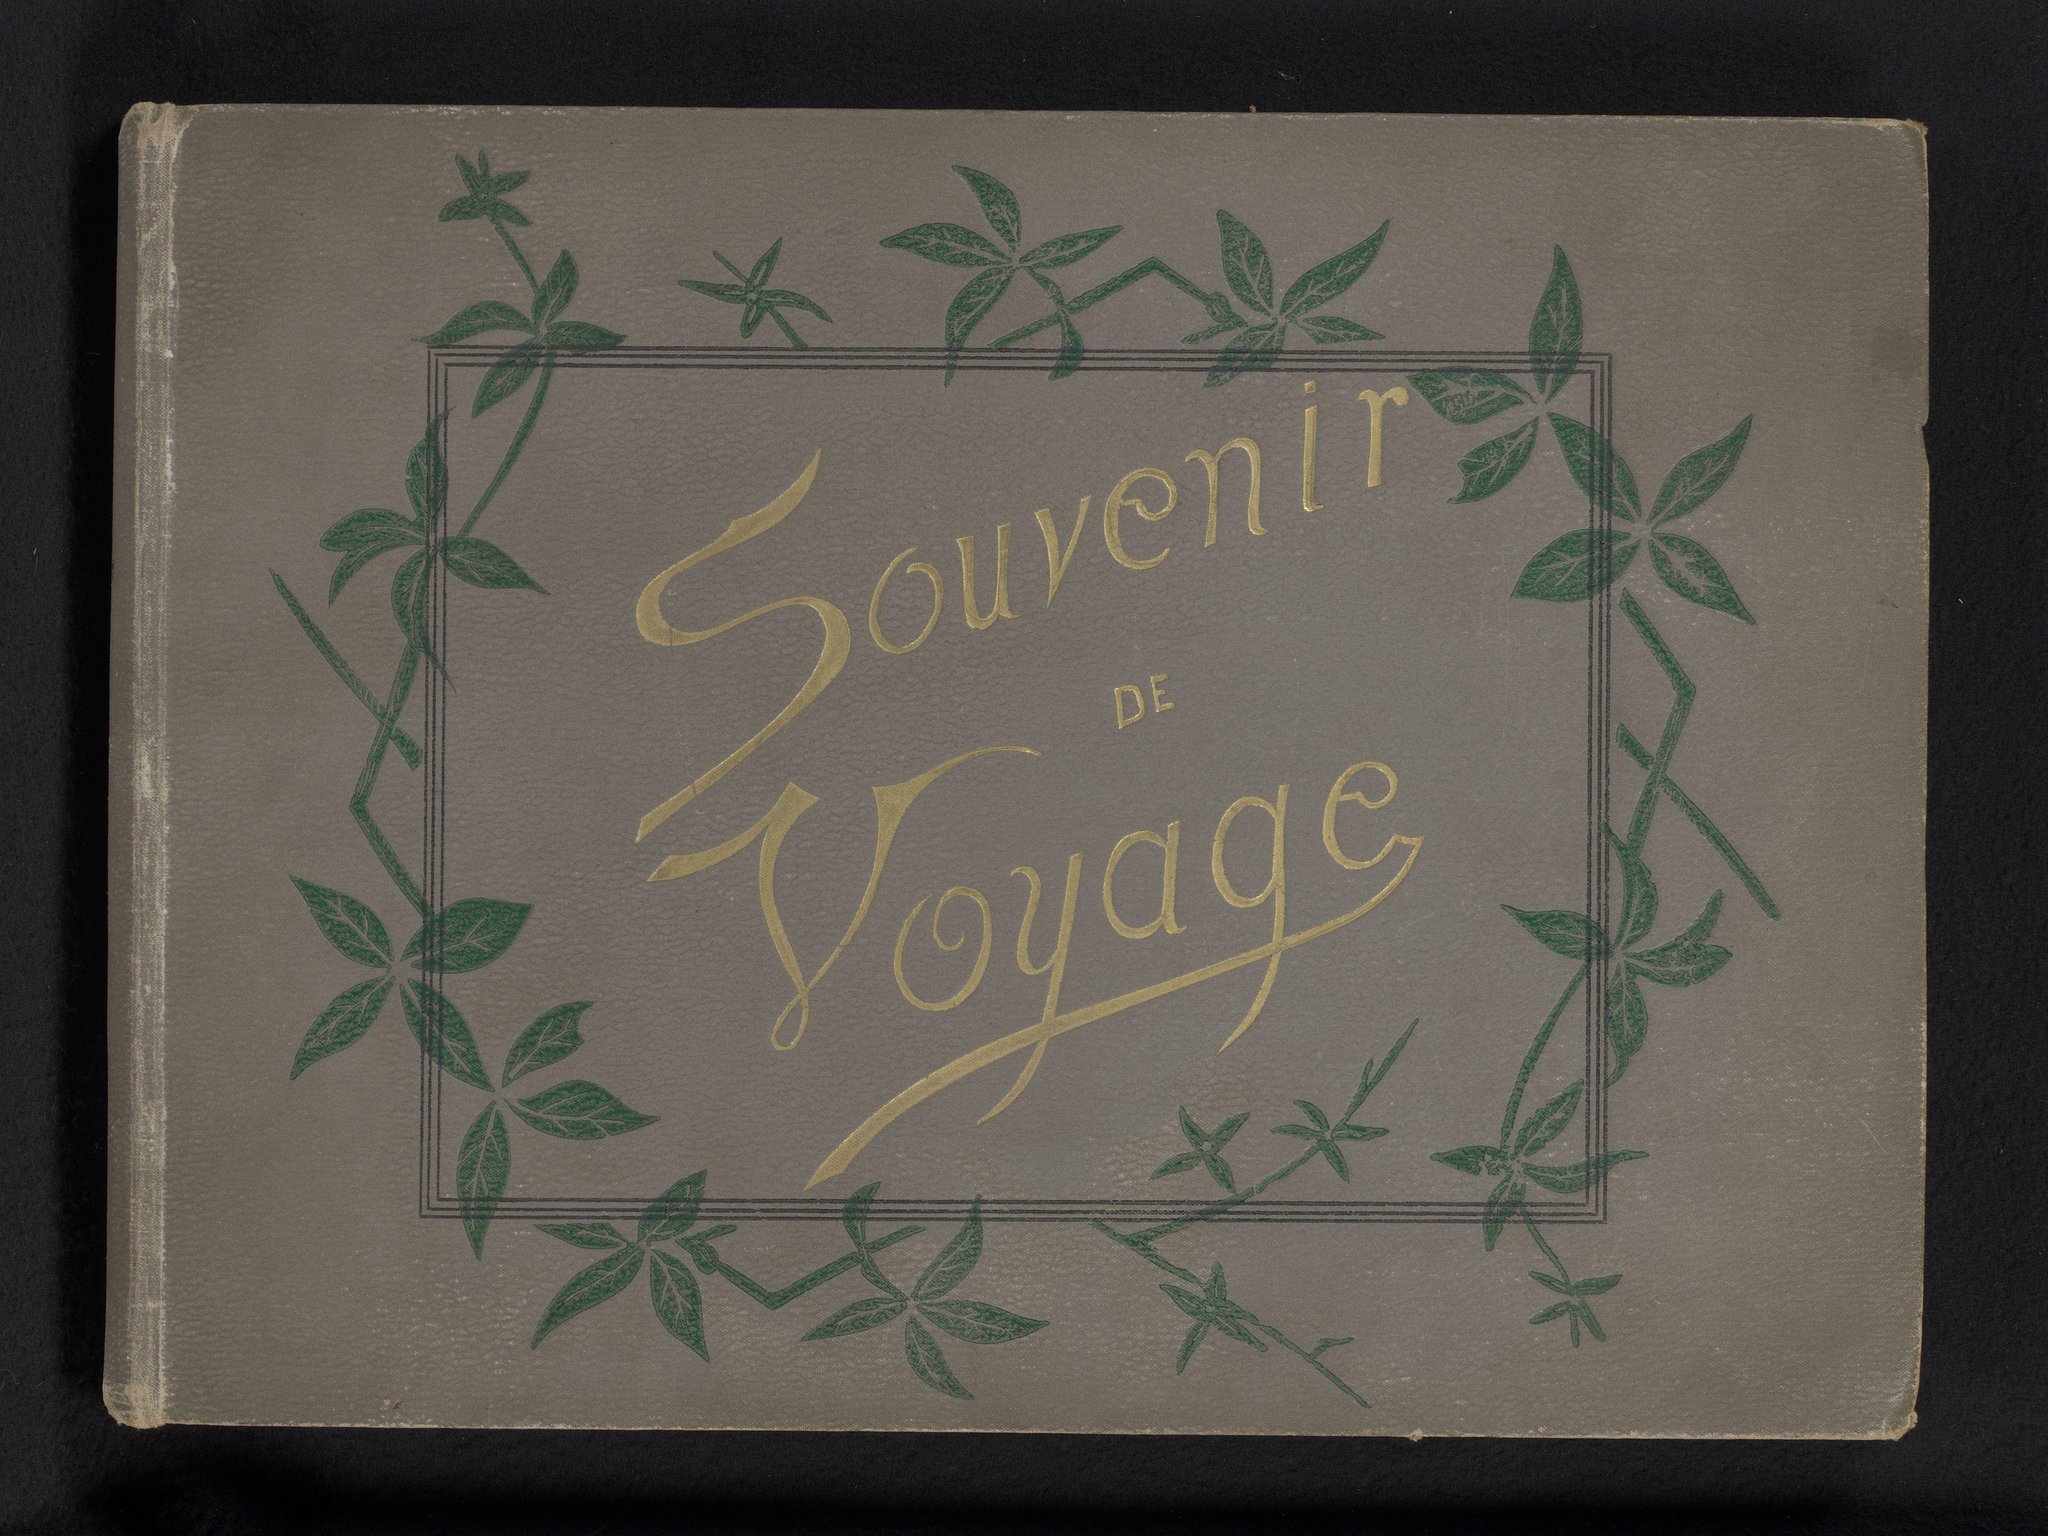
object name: scrapbook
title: Reisalbum Nederlands-Indië, Egypte en Engeland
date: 1885-1910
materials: cardboard, linen, photographic support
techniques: albumen print, photograph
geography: dutch east indies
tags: dutch east indies, the, england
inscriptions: annotation: ‘86 fotos 34 Ned Indië/ 9 Penang/ 9 Suez Kanaal/ 6 Engeland/ 2 Duitse Oorlogsschepen/ 3 Duitsland/ 25 Ned Indië’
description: Fotoalbum met 70 pagina's met in totaal 86 foto's. Het album bevat voornamelijk opnamen gemaakt in Nederlands-Indië maar ook enkele opnamen uit Egypte en Newcastle. Bevat foto's van de Lombokexpeditie in 1894.